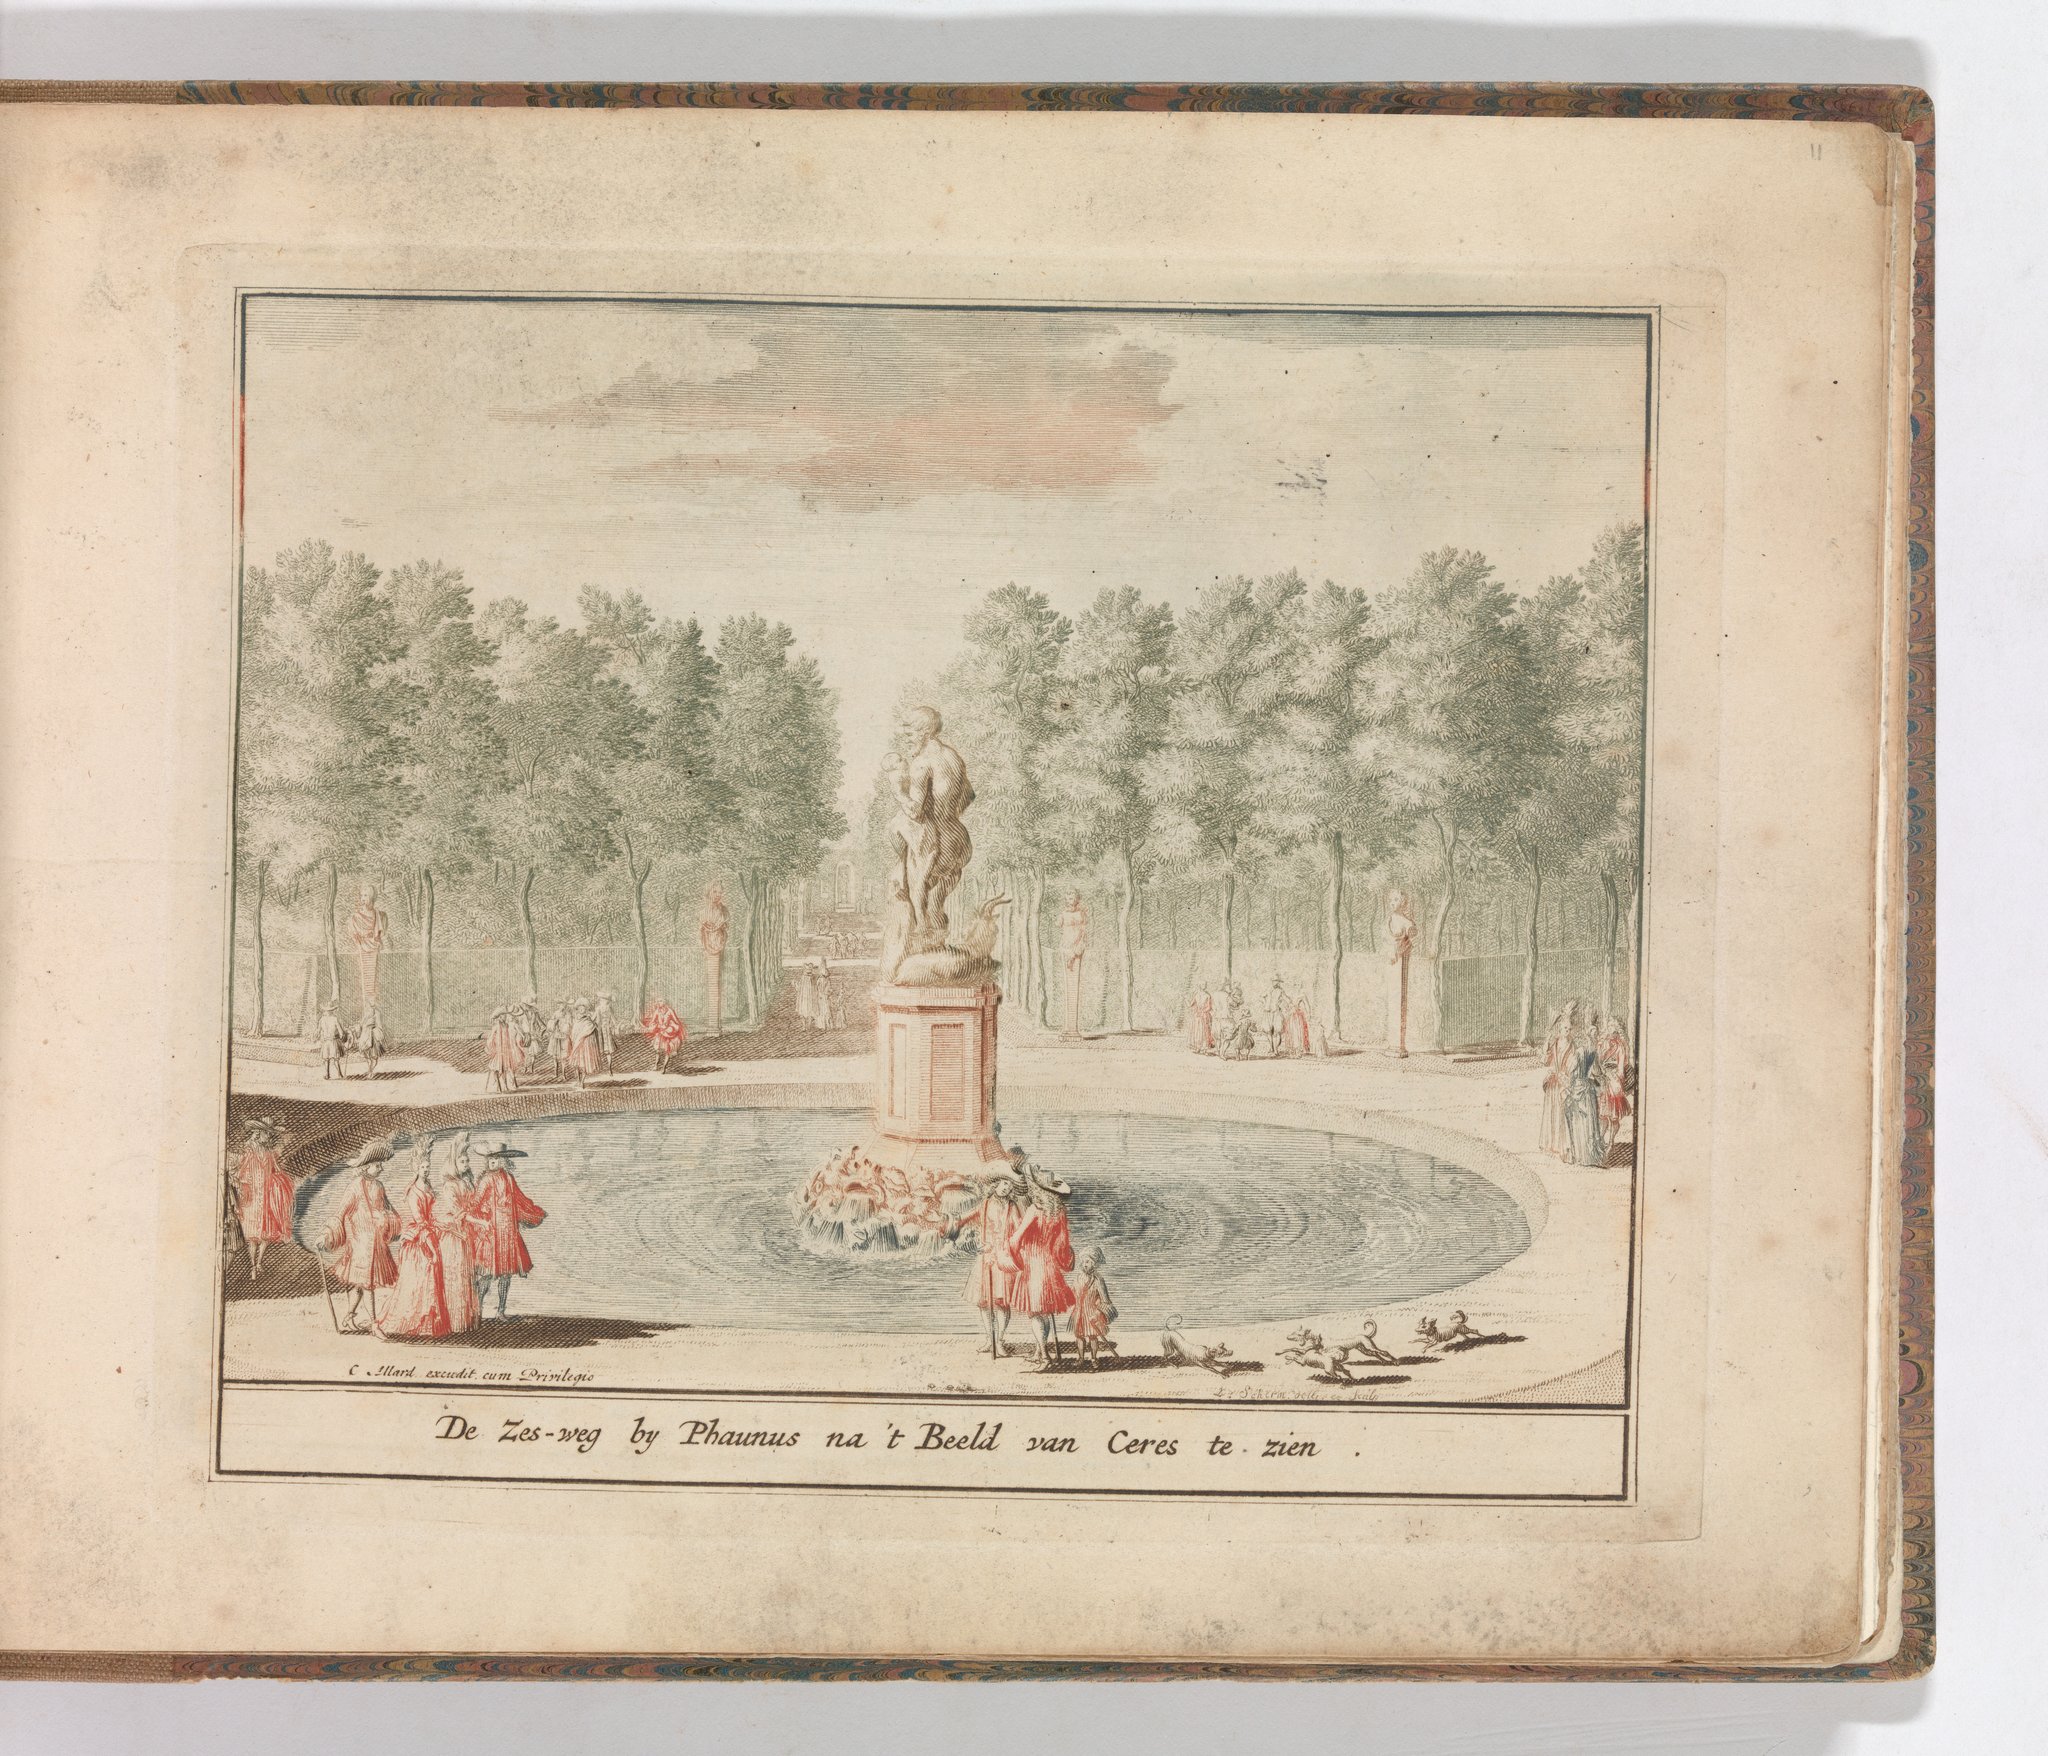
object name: book print ornament architecture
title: 'De Zes-weg by Phaunus na 't Beeld van Ceres te zien', in: Tooneel Der Voornaamste Nederlands Huizen, En Lust Hoven, Naar T Leven Afgebeeld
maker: carel allard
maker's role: publisher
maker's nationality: dutch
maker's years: 1648-1709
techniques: engraving, lithography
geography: amsterdam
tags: human figures,sculpture